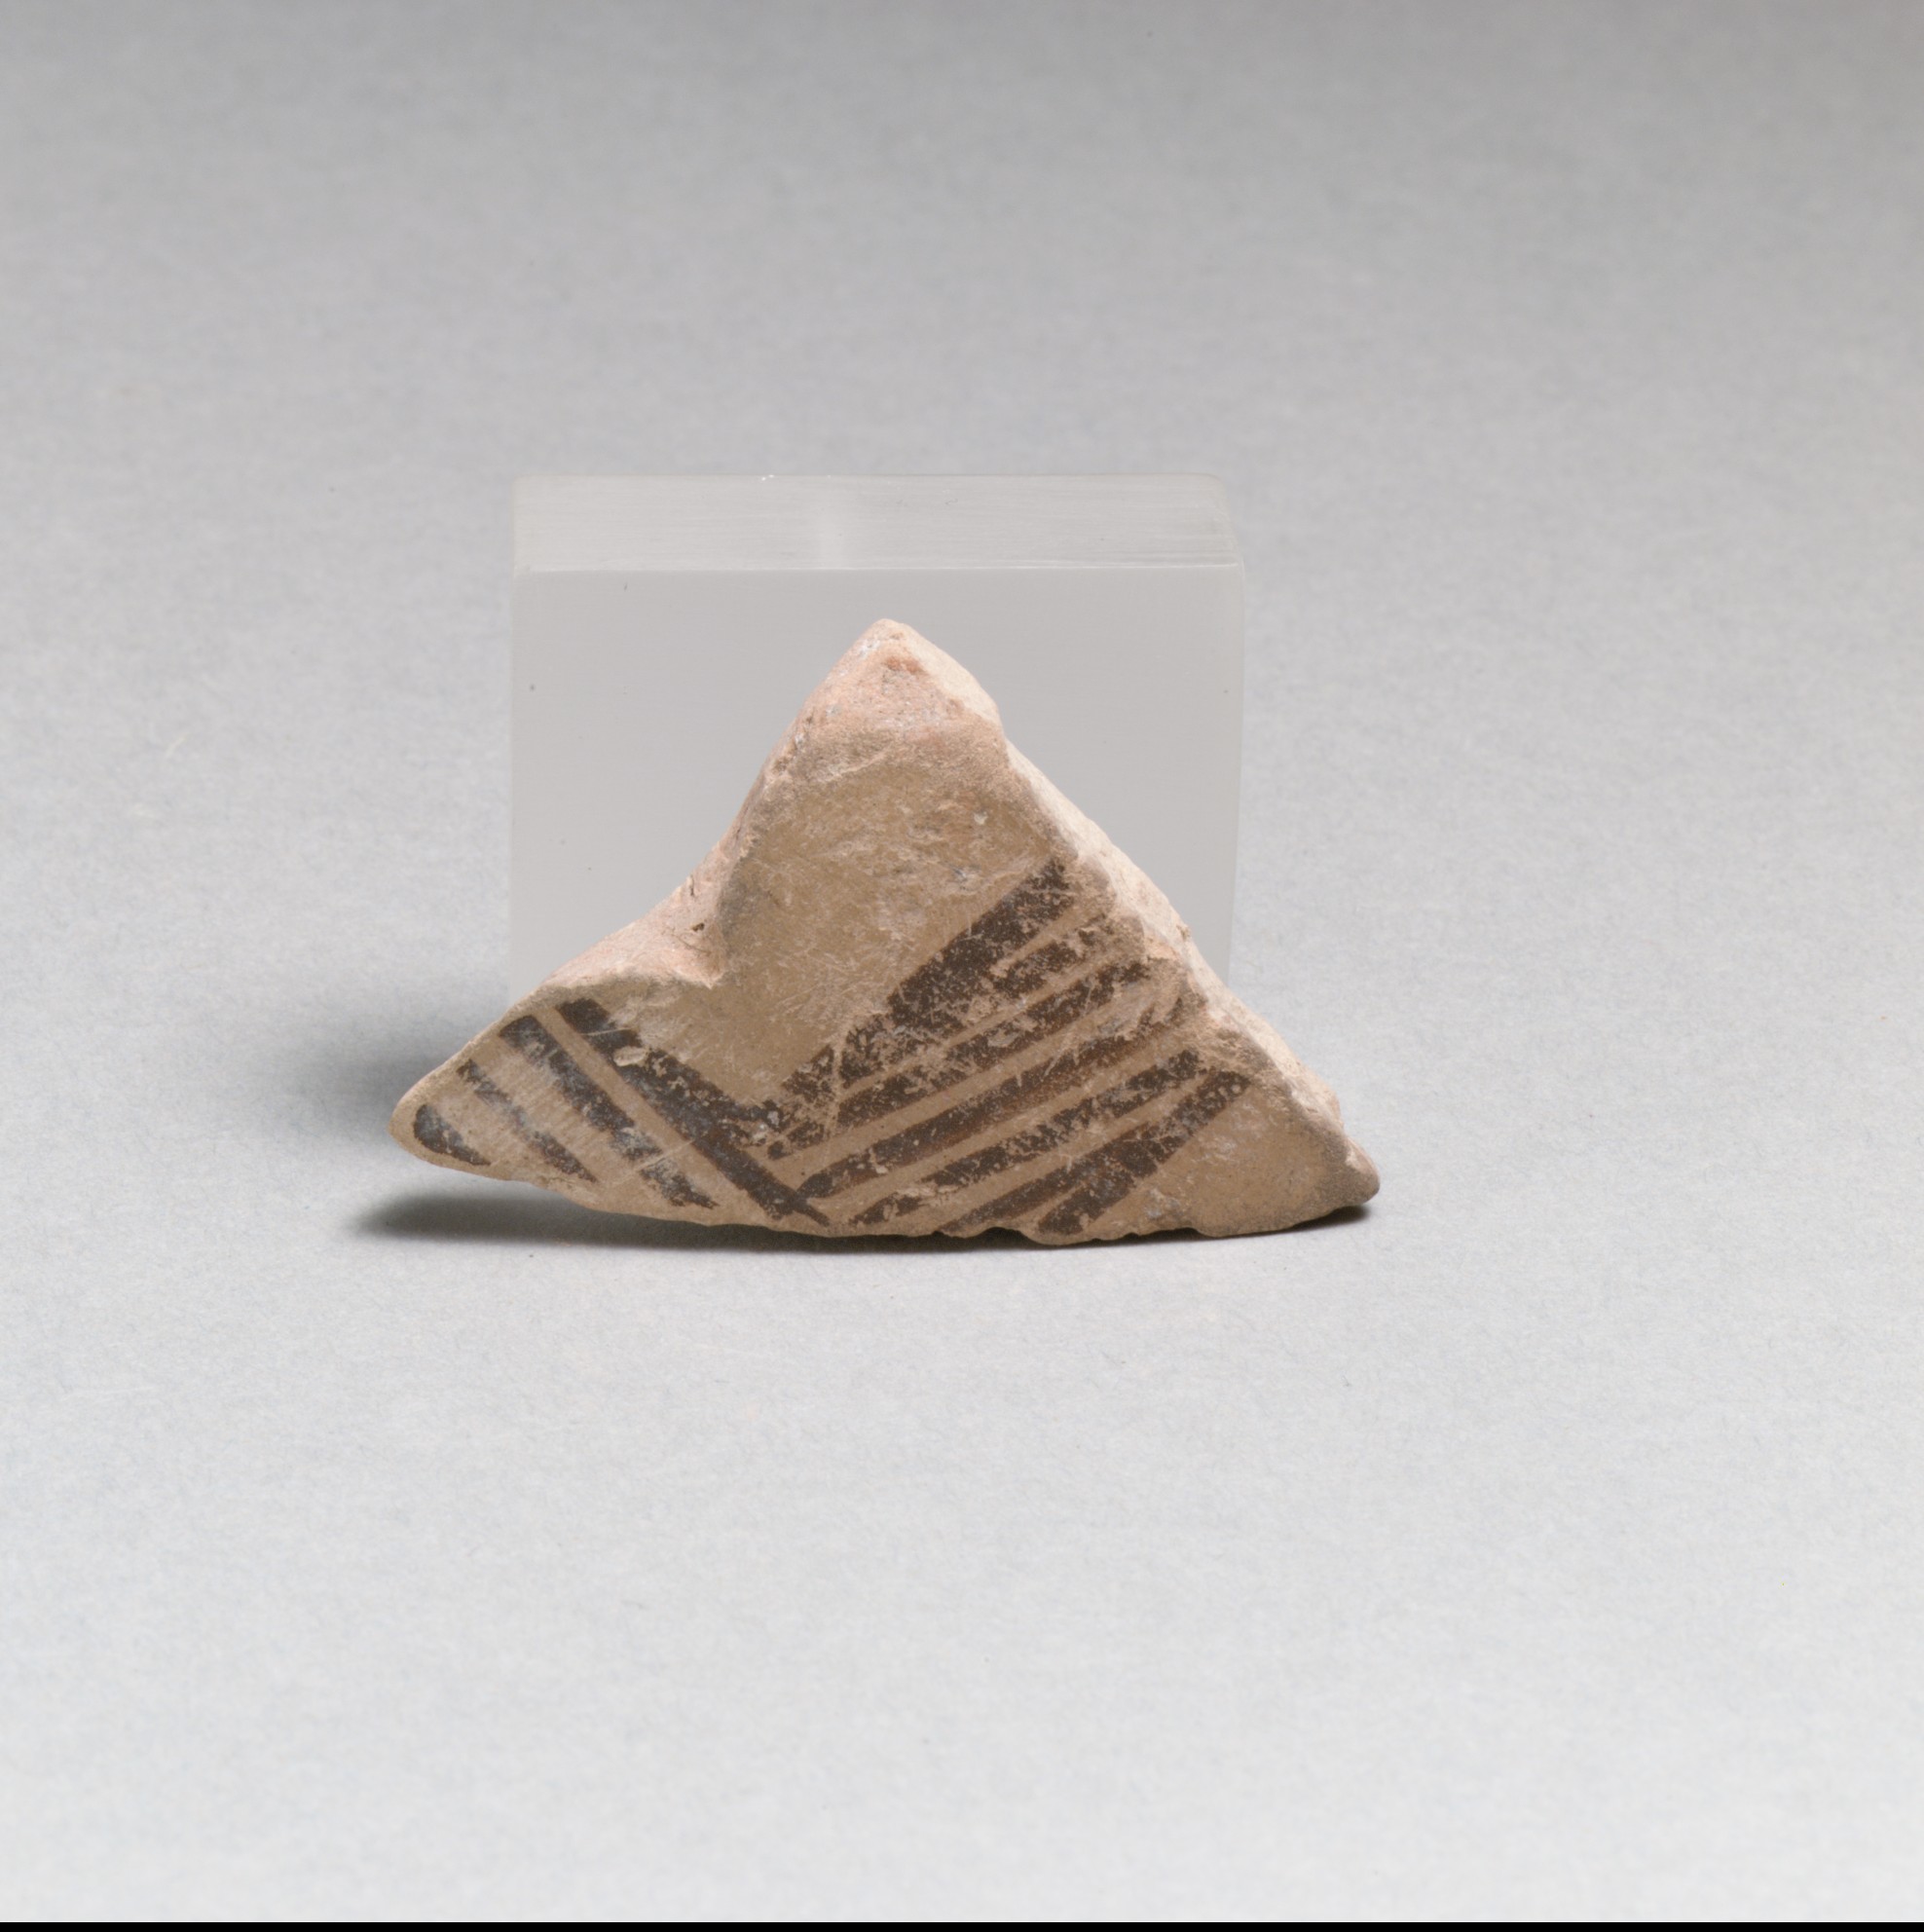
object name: vase fragment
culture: neolithic, thessaly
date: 4000-3000 BCE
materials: terracotta